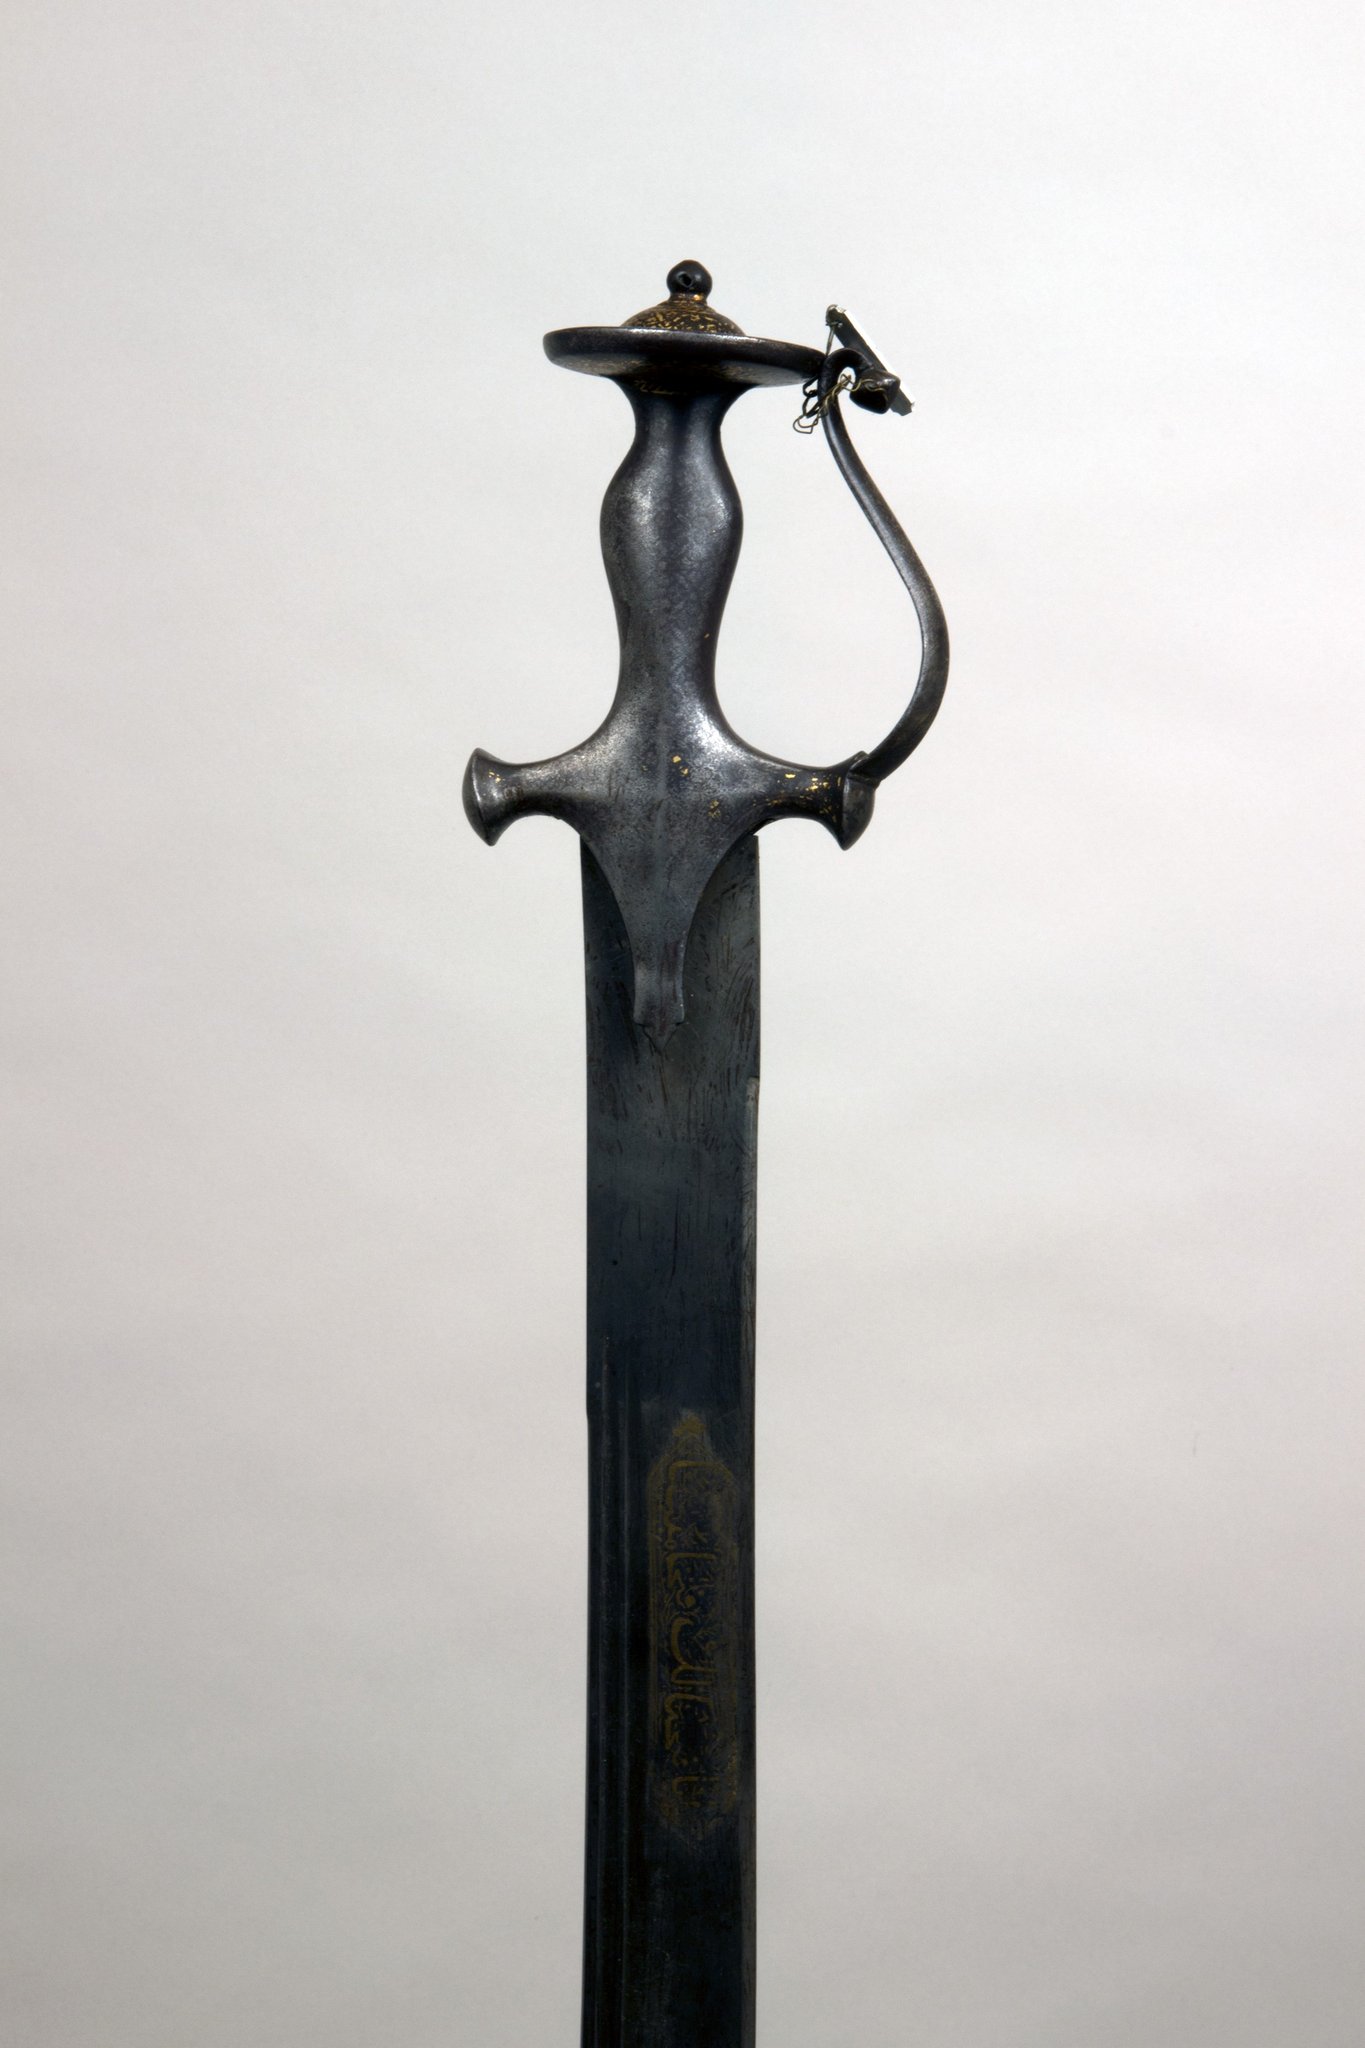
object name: sword shamshir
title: Sword (Shamshir)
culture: indian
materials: gold, iron, steel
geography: india